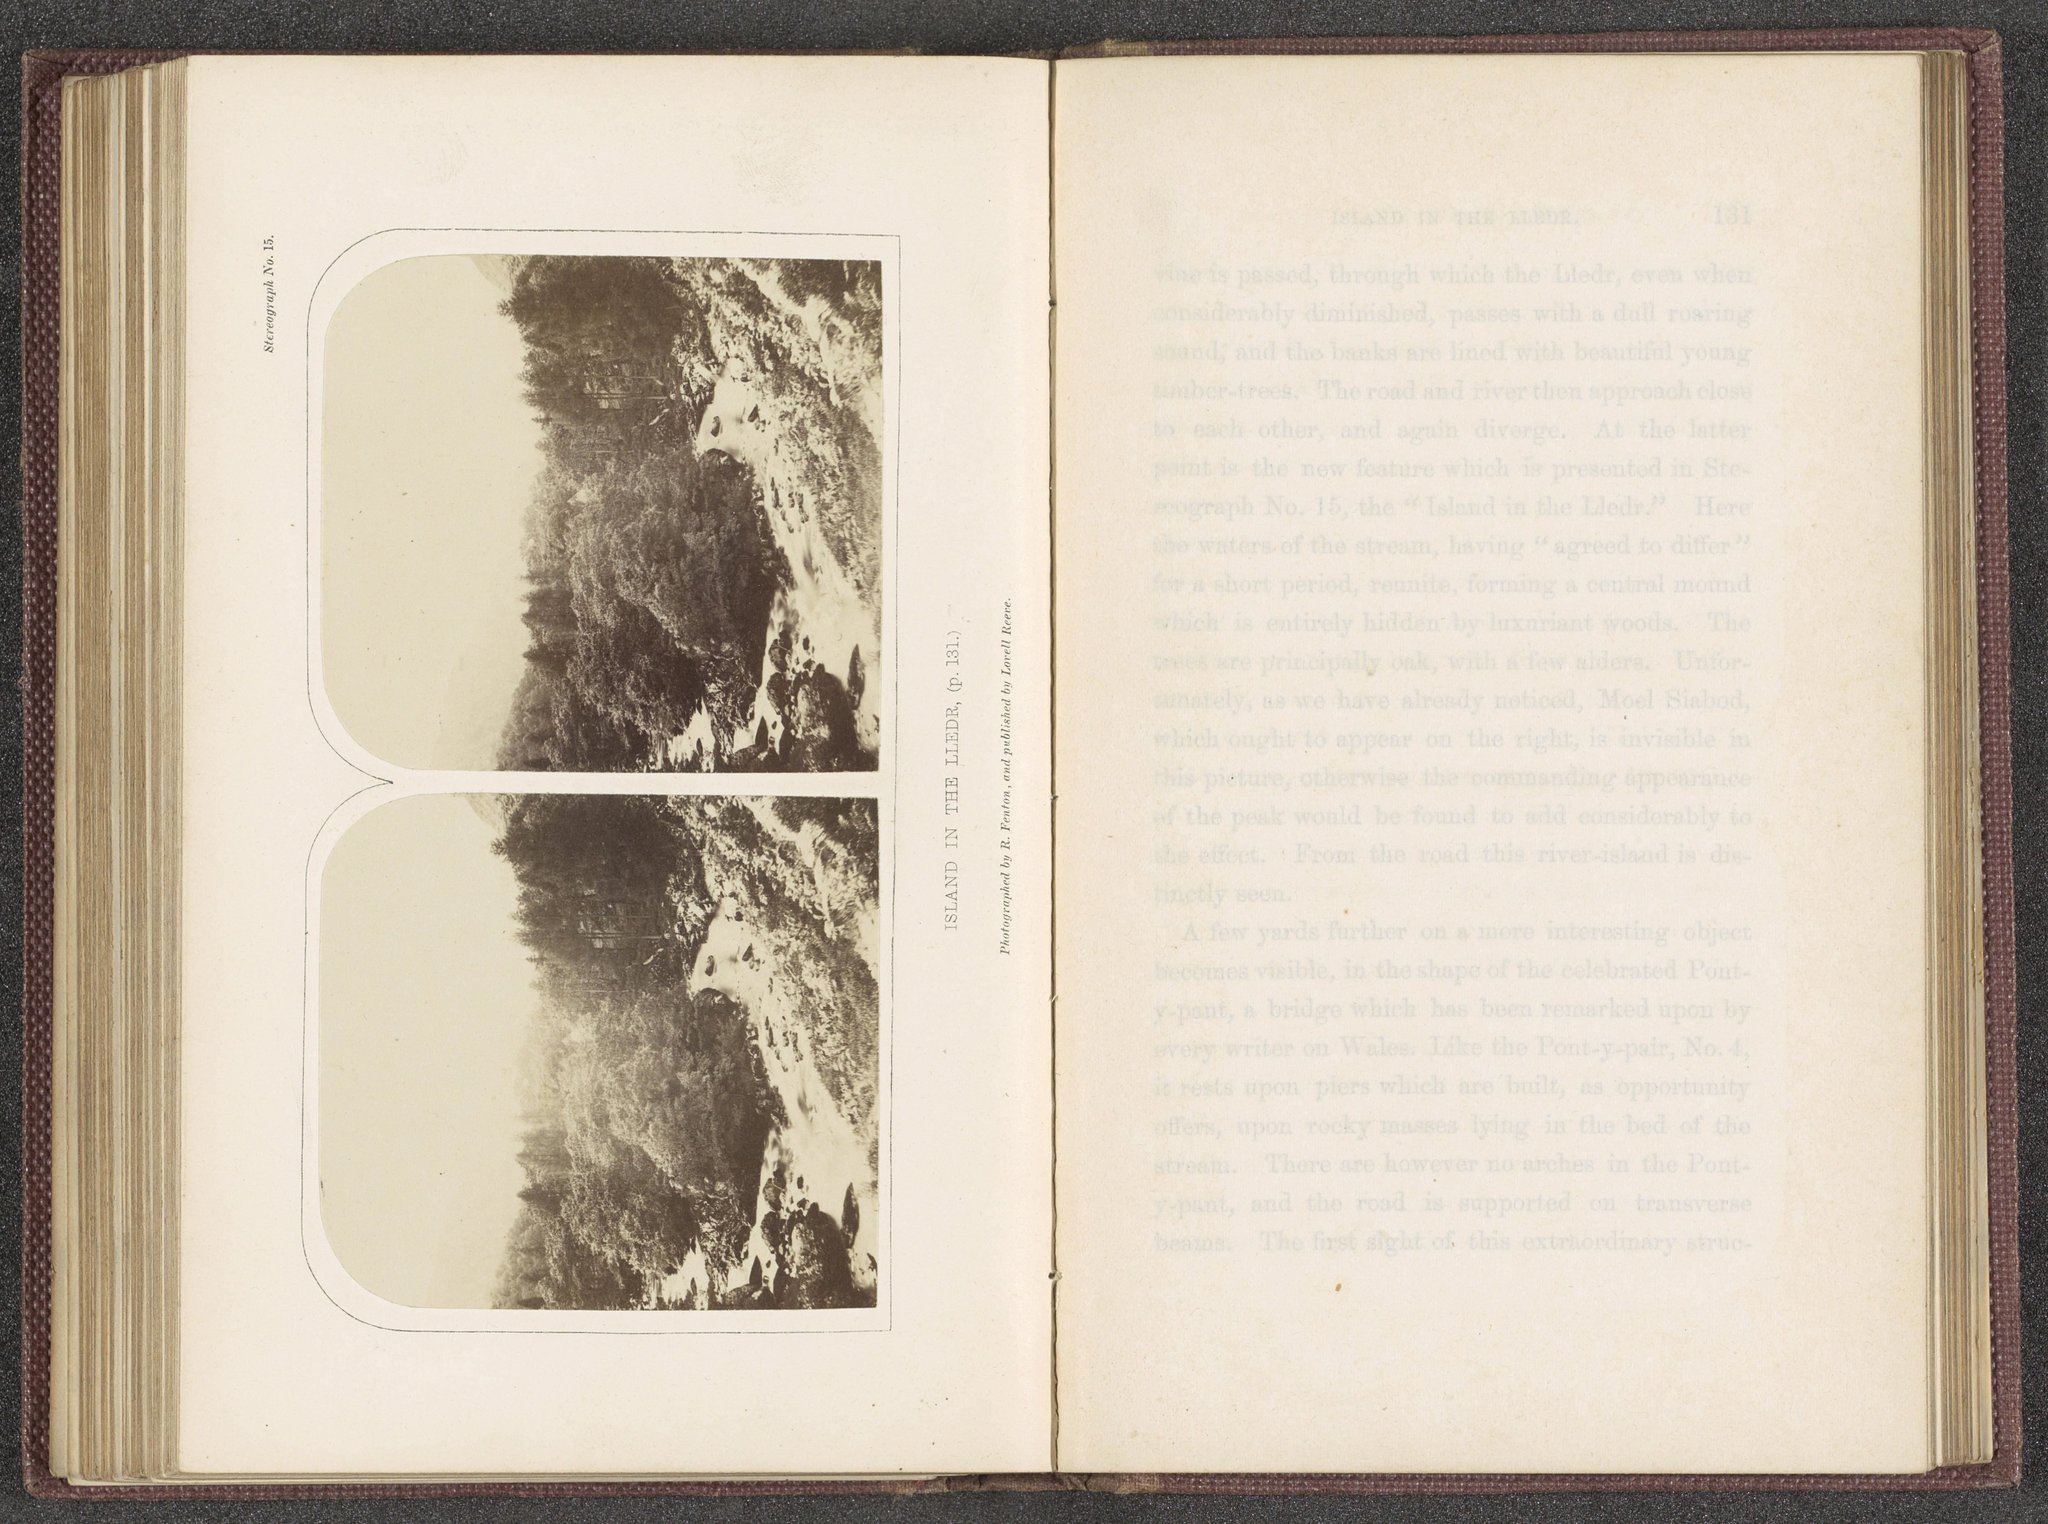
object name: page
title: Island in the Lledr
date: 1859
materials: paper, photographic support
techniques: albumen print, printing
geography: wales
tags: island, river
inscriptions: number: ‘Stereograph No. 15.’